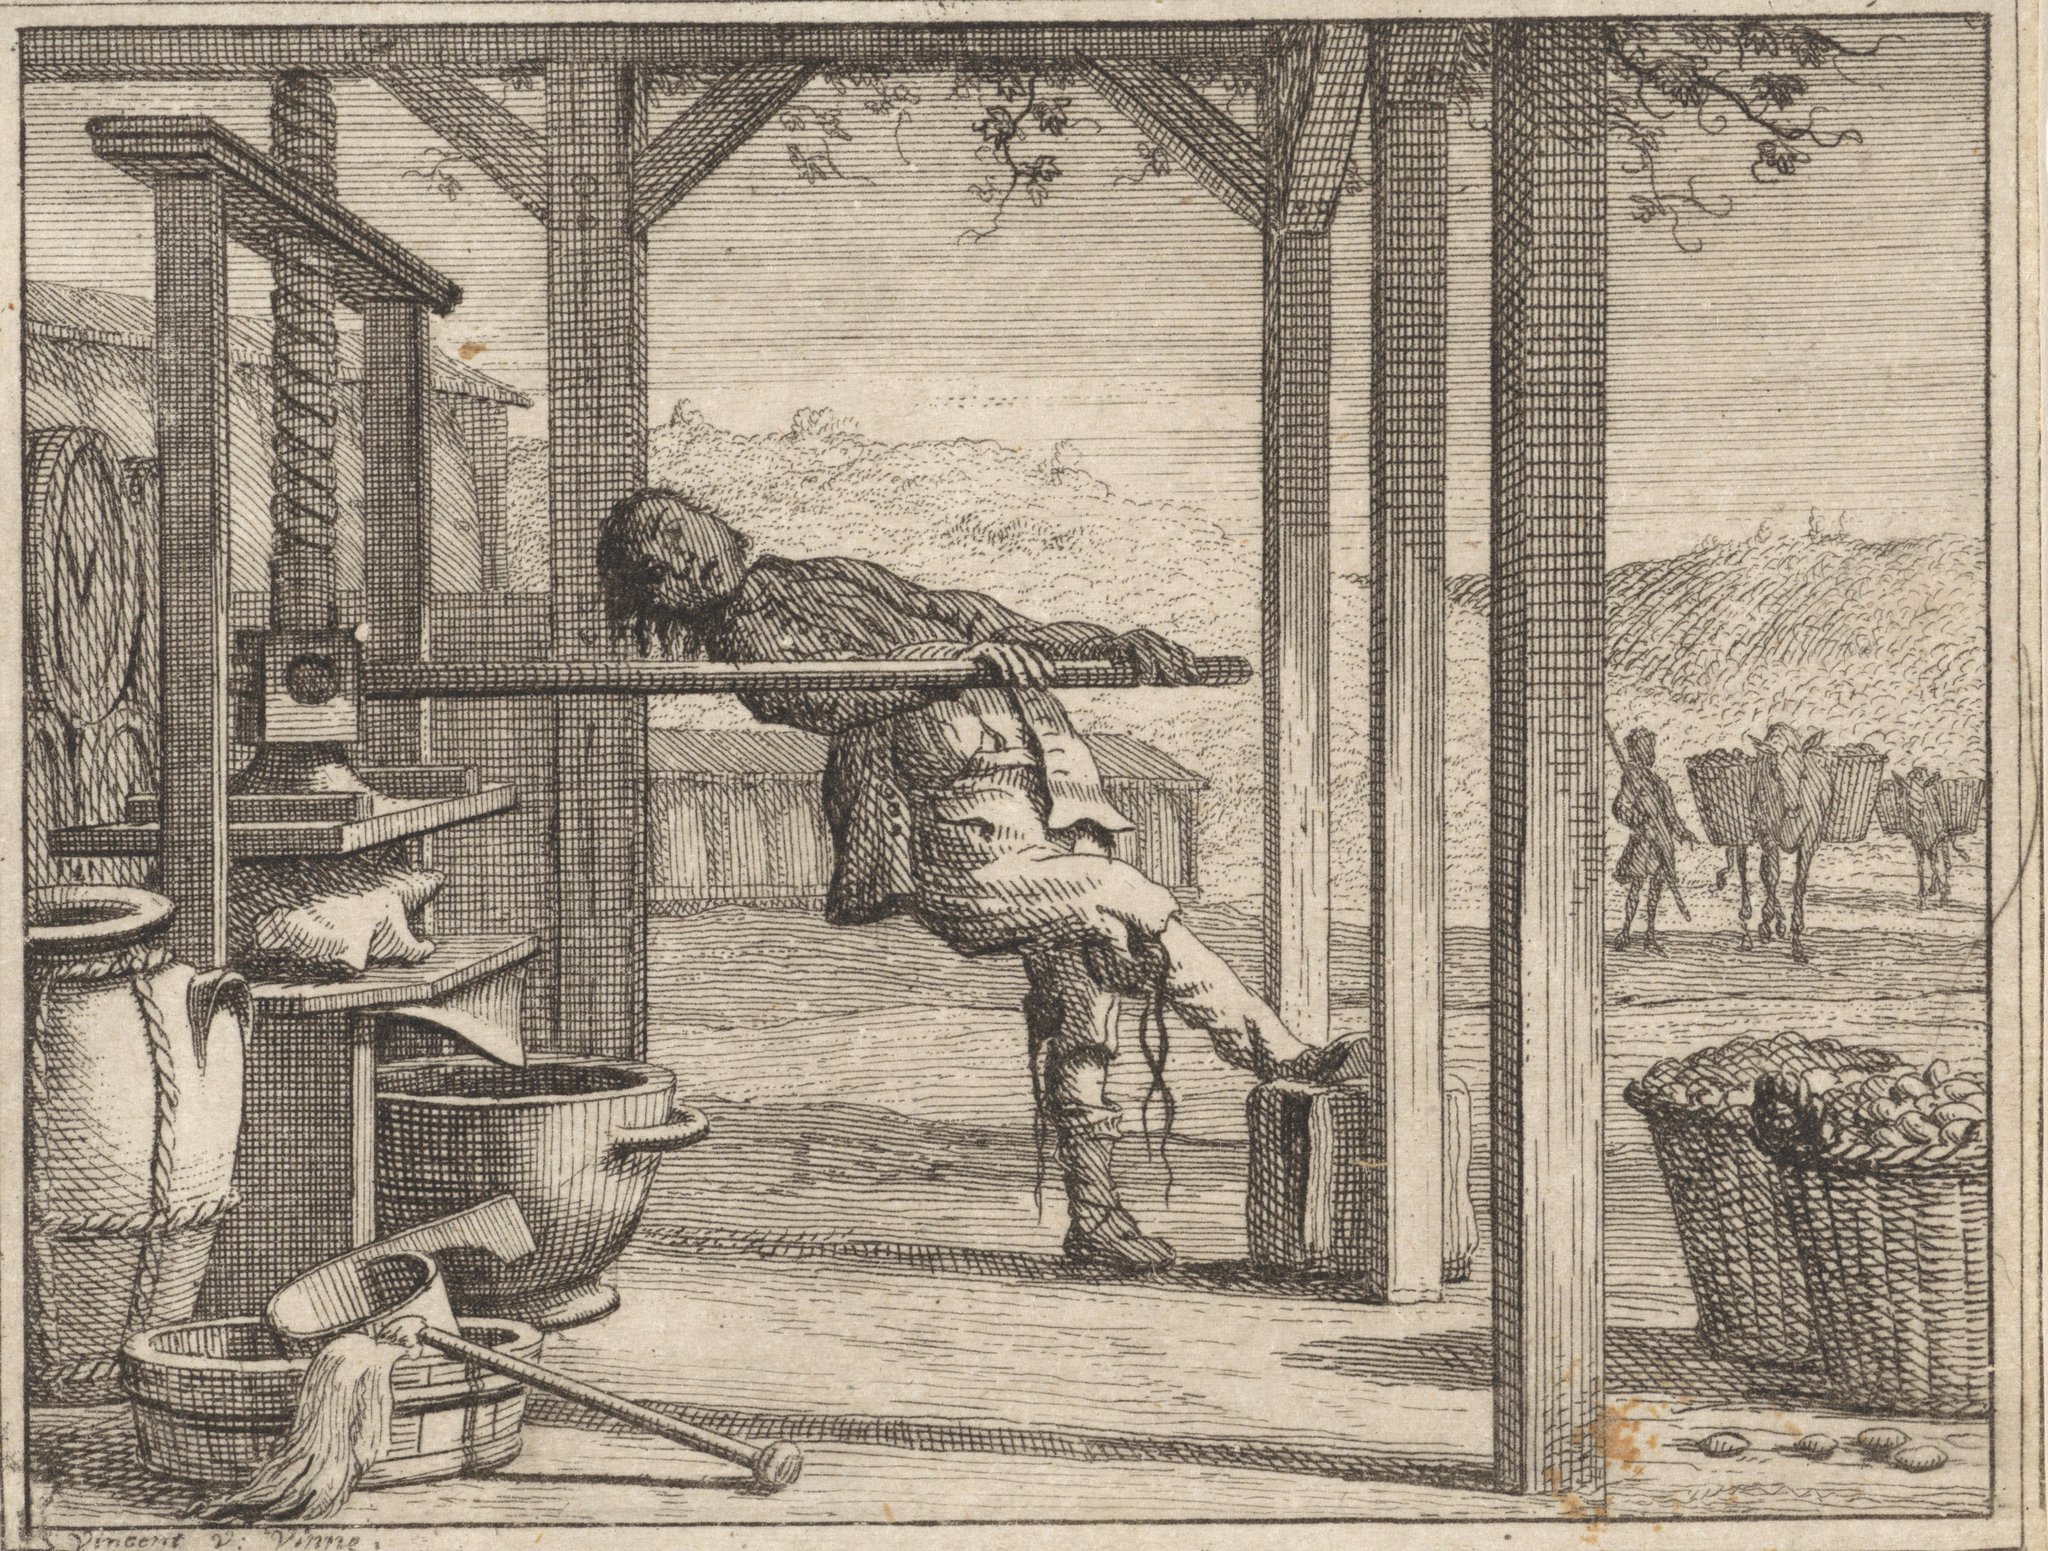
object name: print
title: Man probeert een steen uit te persen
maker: vincent laurensz. van der vinne (ii)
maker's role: draughtsman, print maker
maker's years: 1686-1742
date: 1714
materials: paper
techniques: engraving, etching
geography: haarlem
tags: pressing (industrial process), tools, aids, implements ~ crafts and industries: press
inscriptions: collector's mark: Lugt 2228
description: Prent gebruikt als boekillustratie in: Spinniker, Adriaan. Leerzaame zinnebeelden. Haarlem: [boekverkoper] Isaak van der Vinne (I) en Amsterdam: [drukker] Johannes Krelius, 1714.